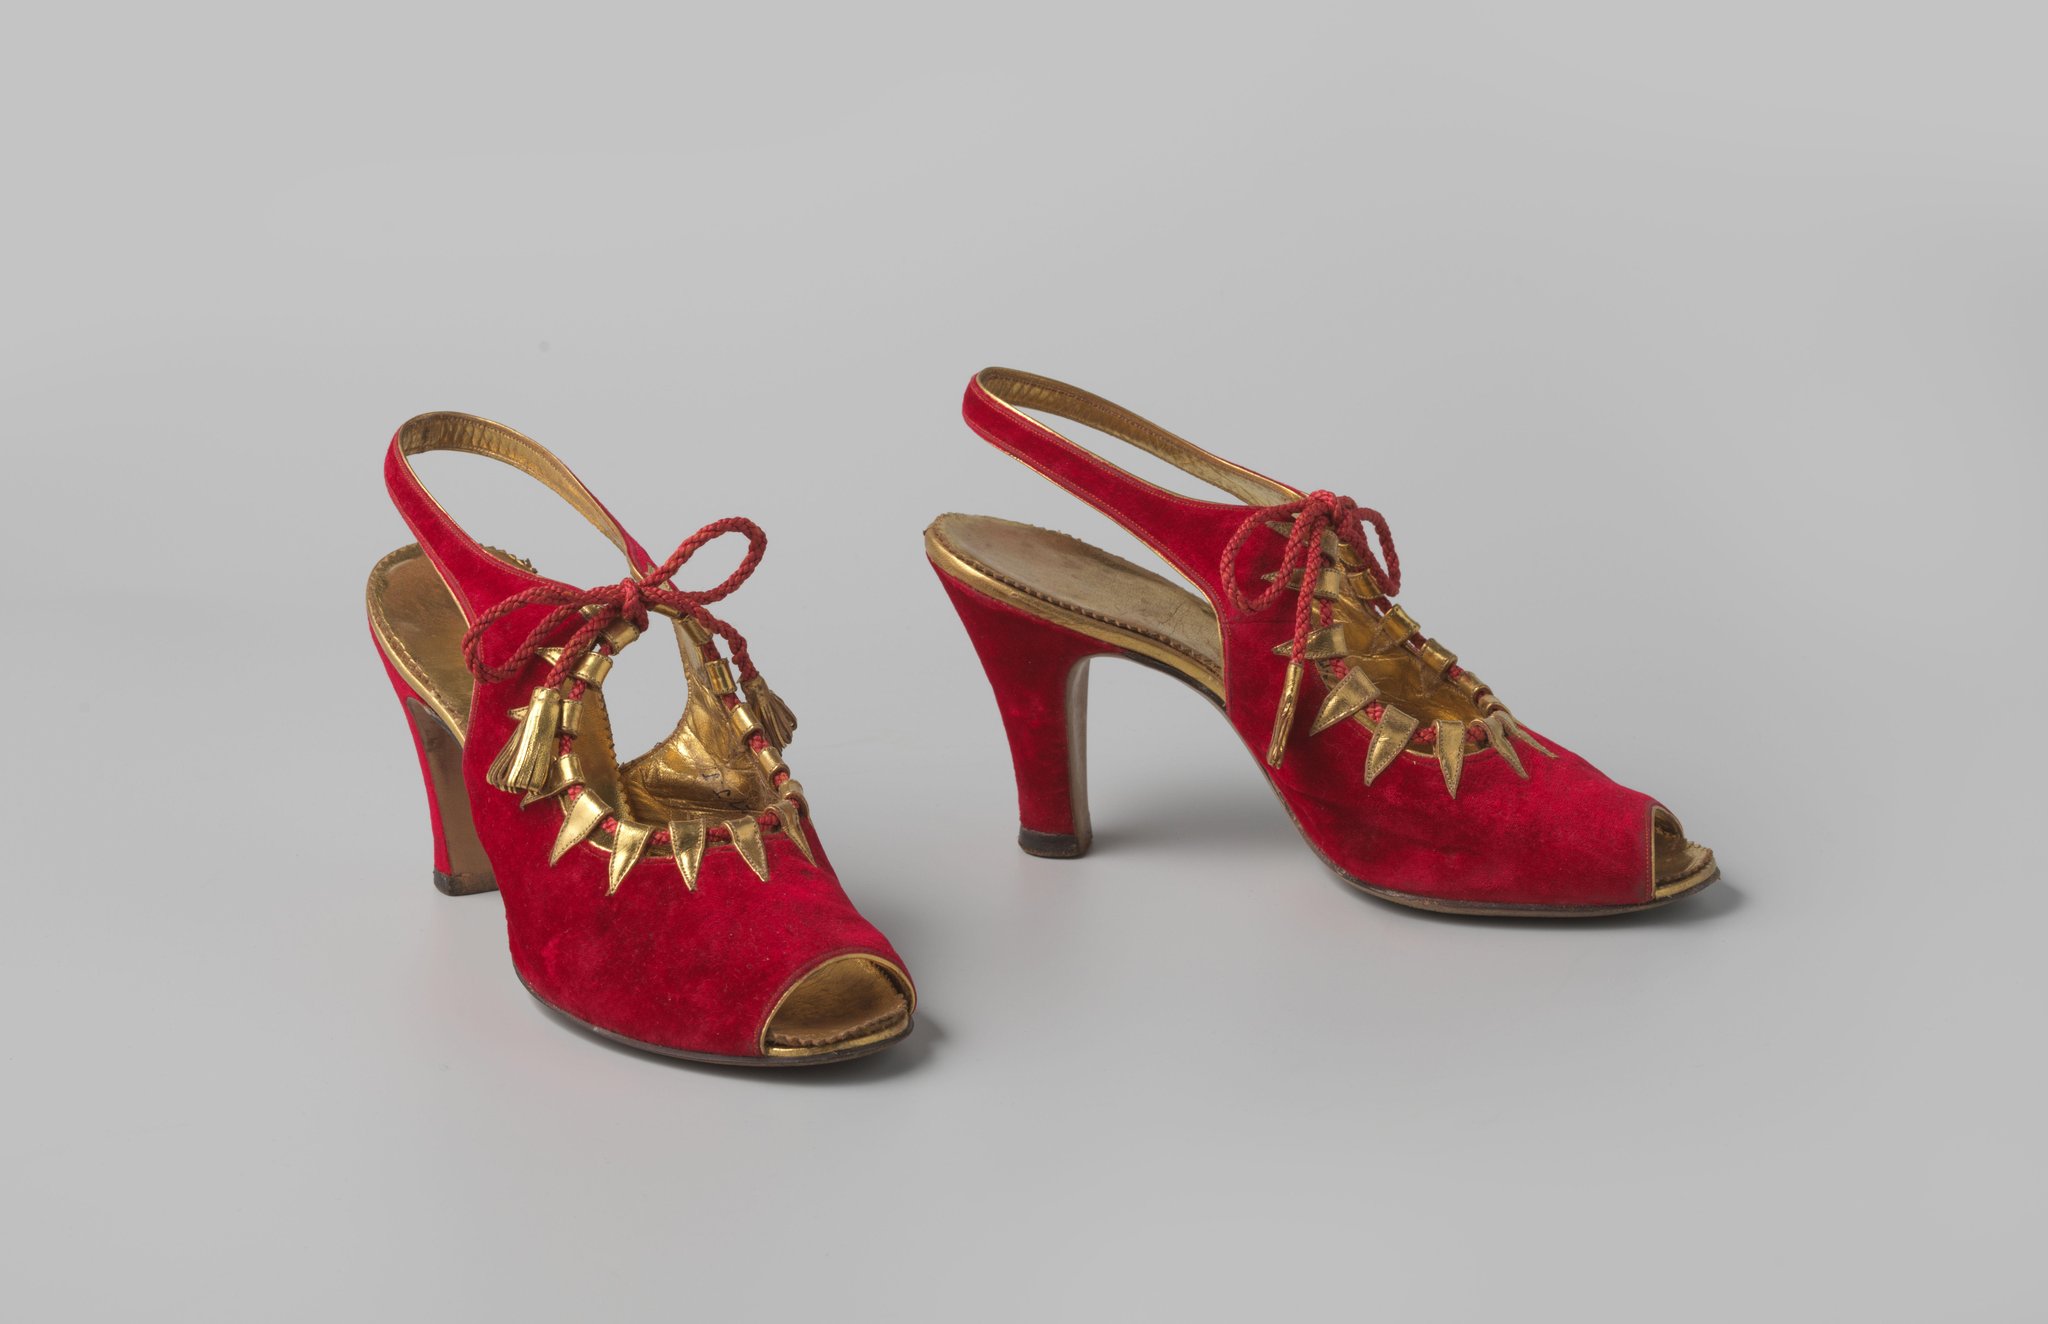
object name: shoe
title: Damesschoenen (avondschoen) van rood fluweel afgezet met goudkleurig leer (rechts)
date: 1930-1940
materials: cotton, leather, silk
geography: london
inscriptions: : ‘27 J.J. / 5.B./8021./5350.3’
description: Rechterschoen van paar damesschoenen (avondschoenen) van rood fluweel afgezet met goudkleurig leer. Model: open teen en hiel, sluiting met rood koord met goudkleurige leren franjes, gevoerd met goudkleurig leer.